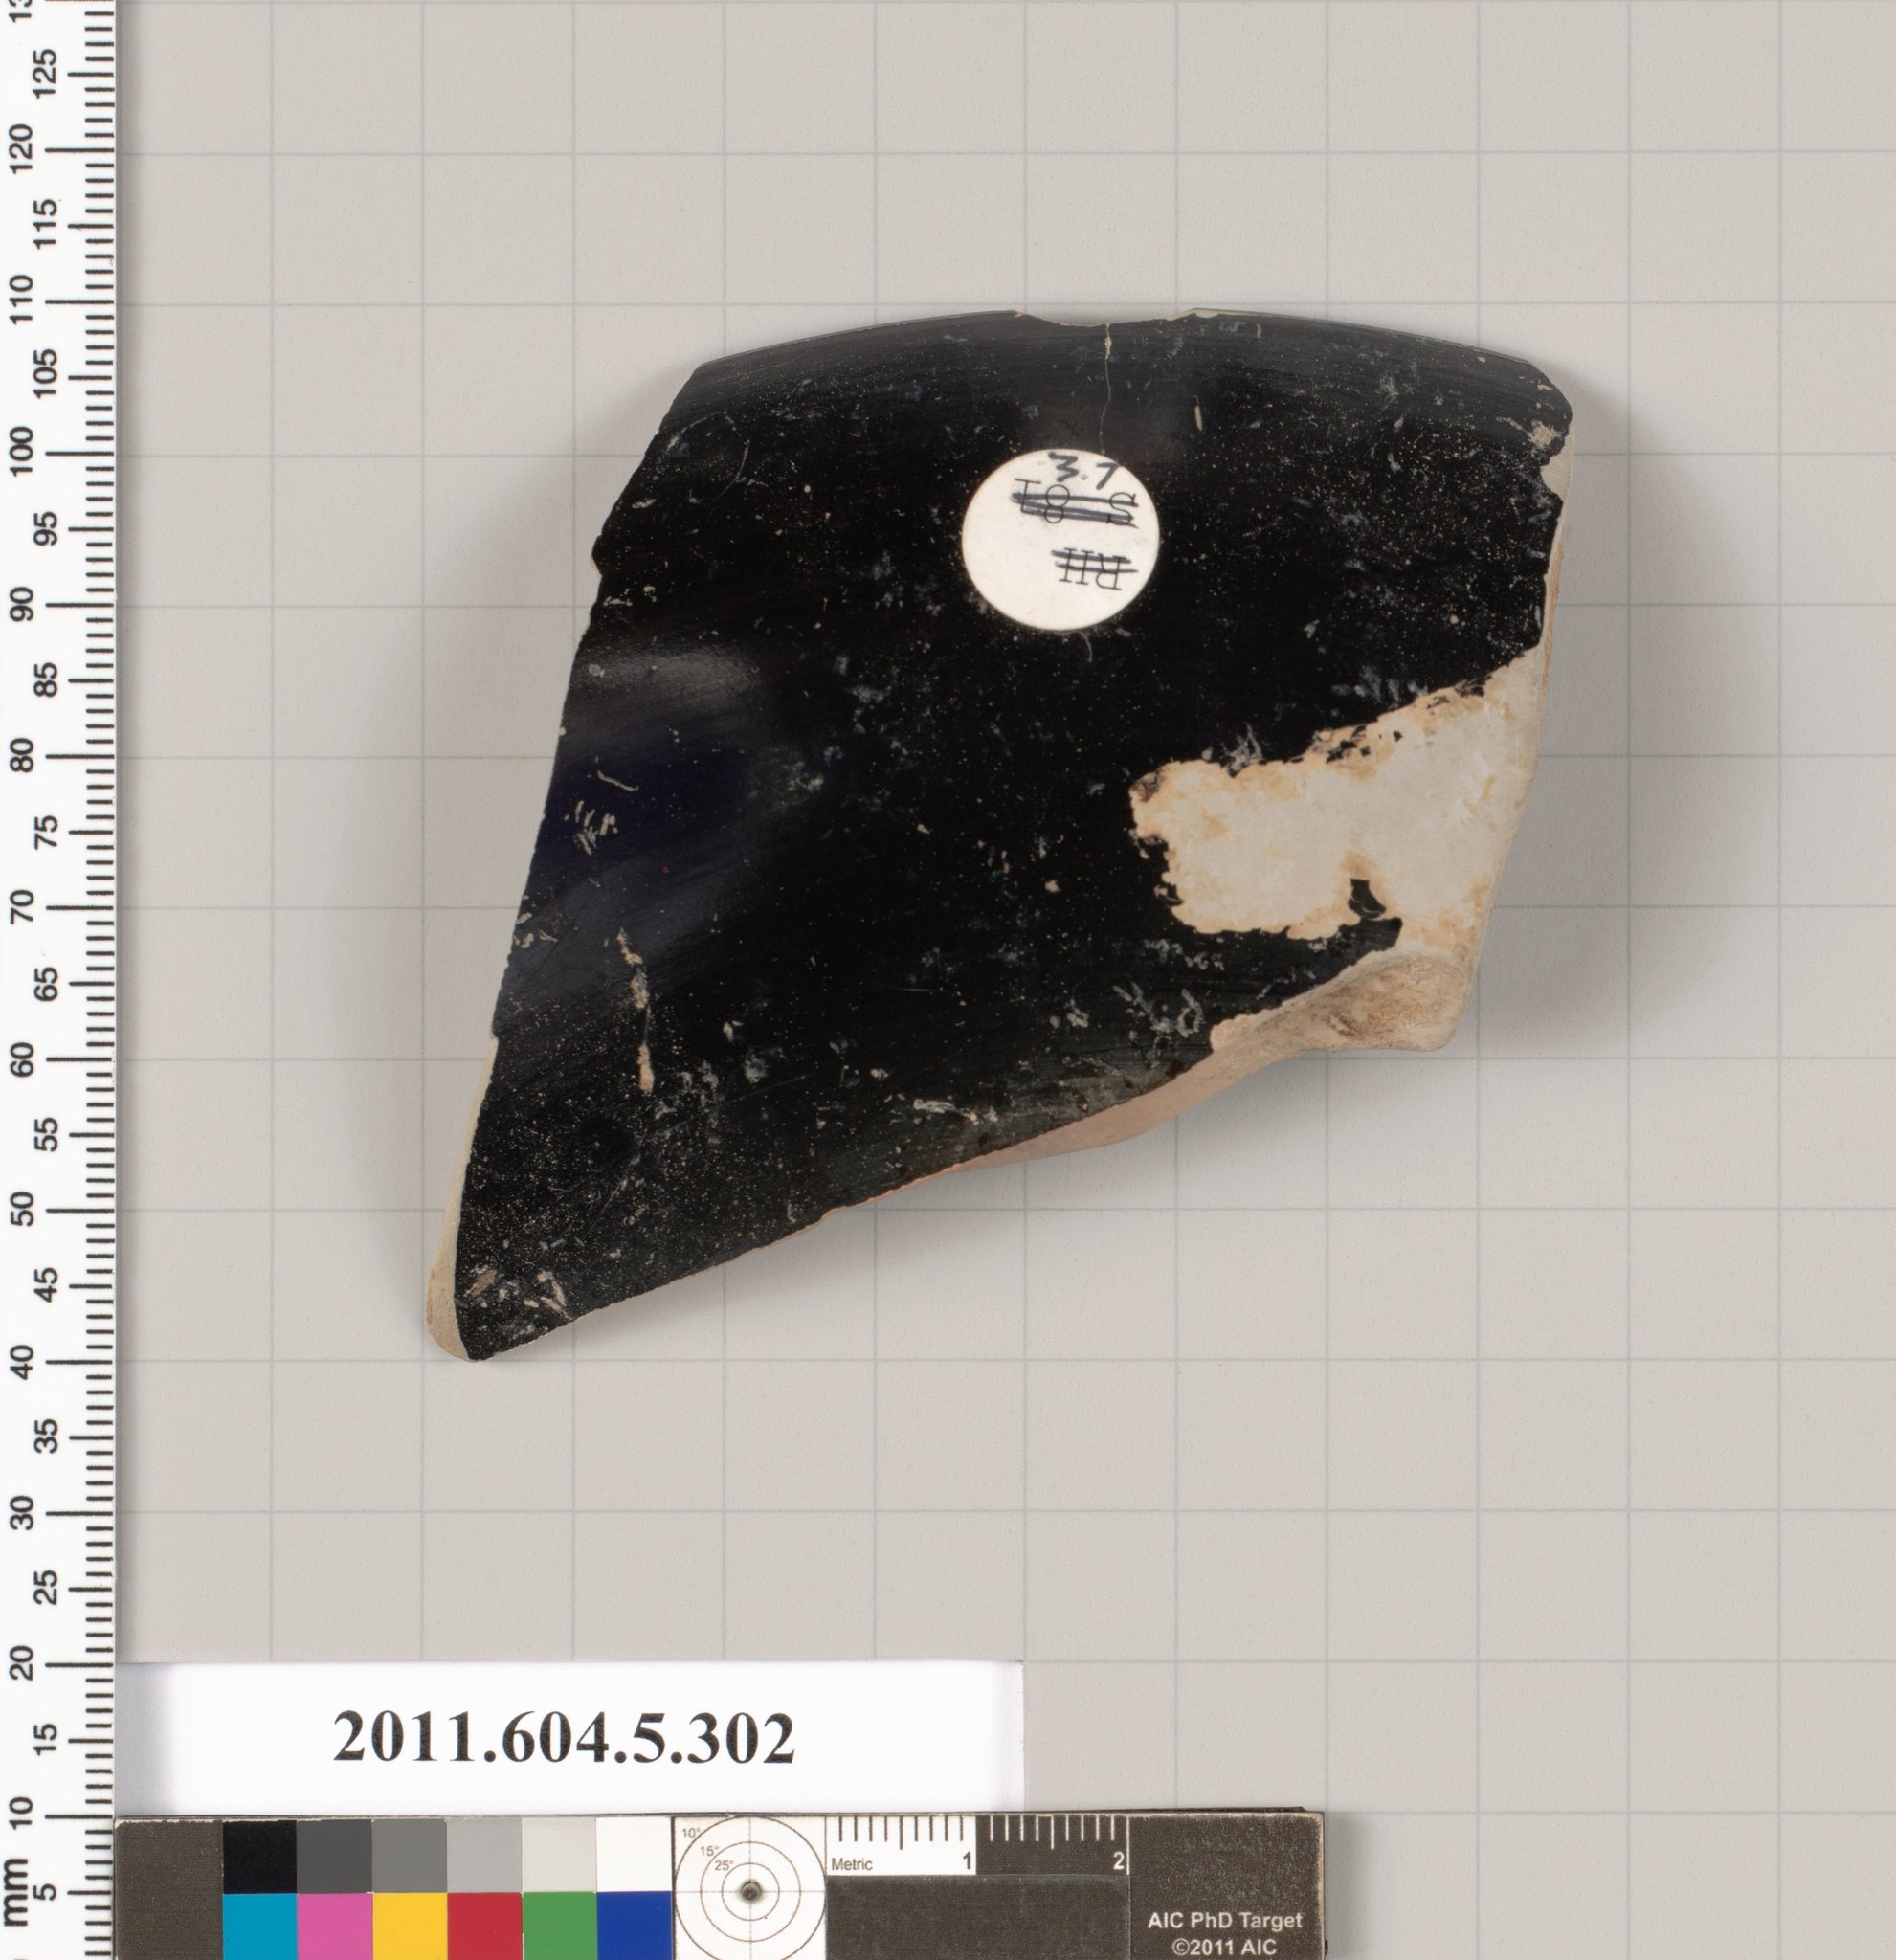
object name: kylix fragment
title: Terracotta rim fragment of a kylix (drinking cup)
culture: greek, attic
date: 600-401 BCE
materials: terracotta